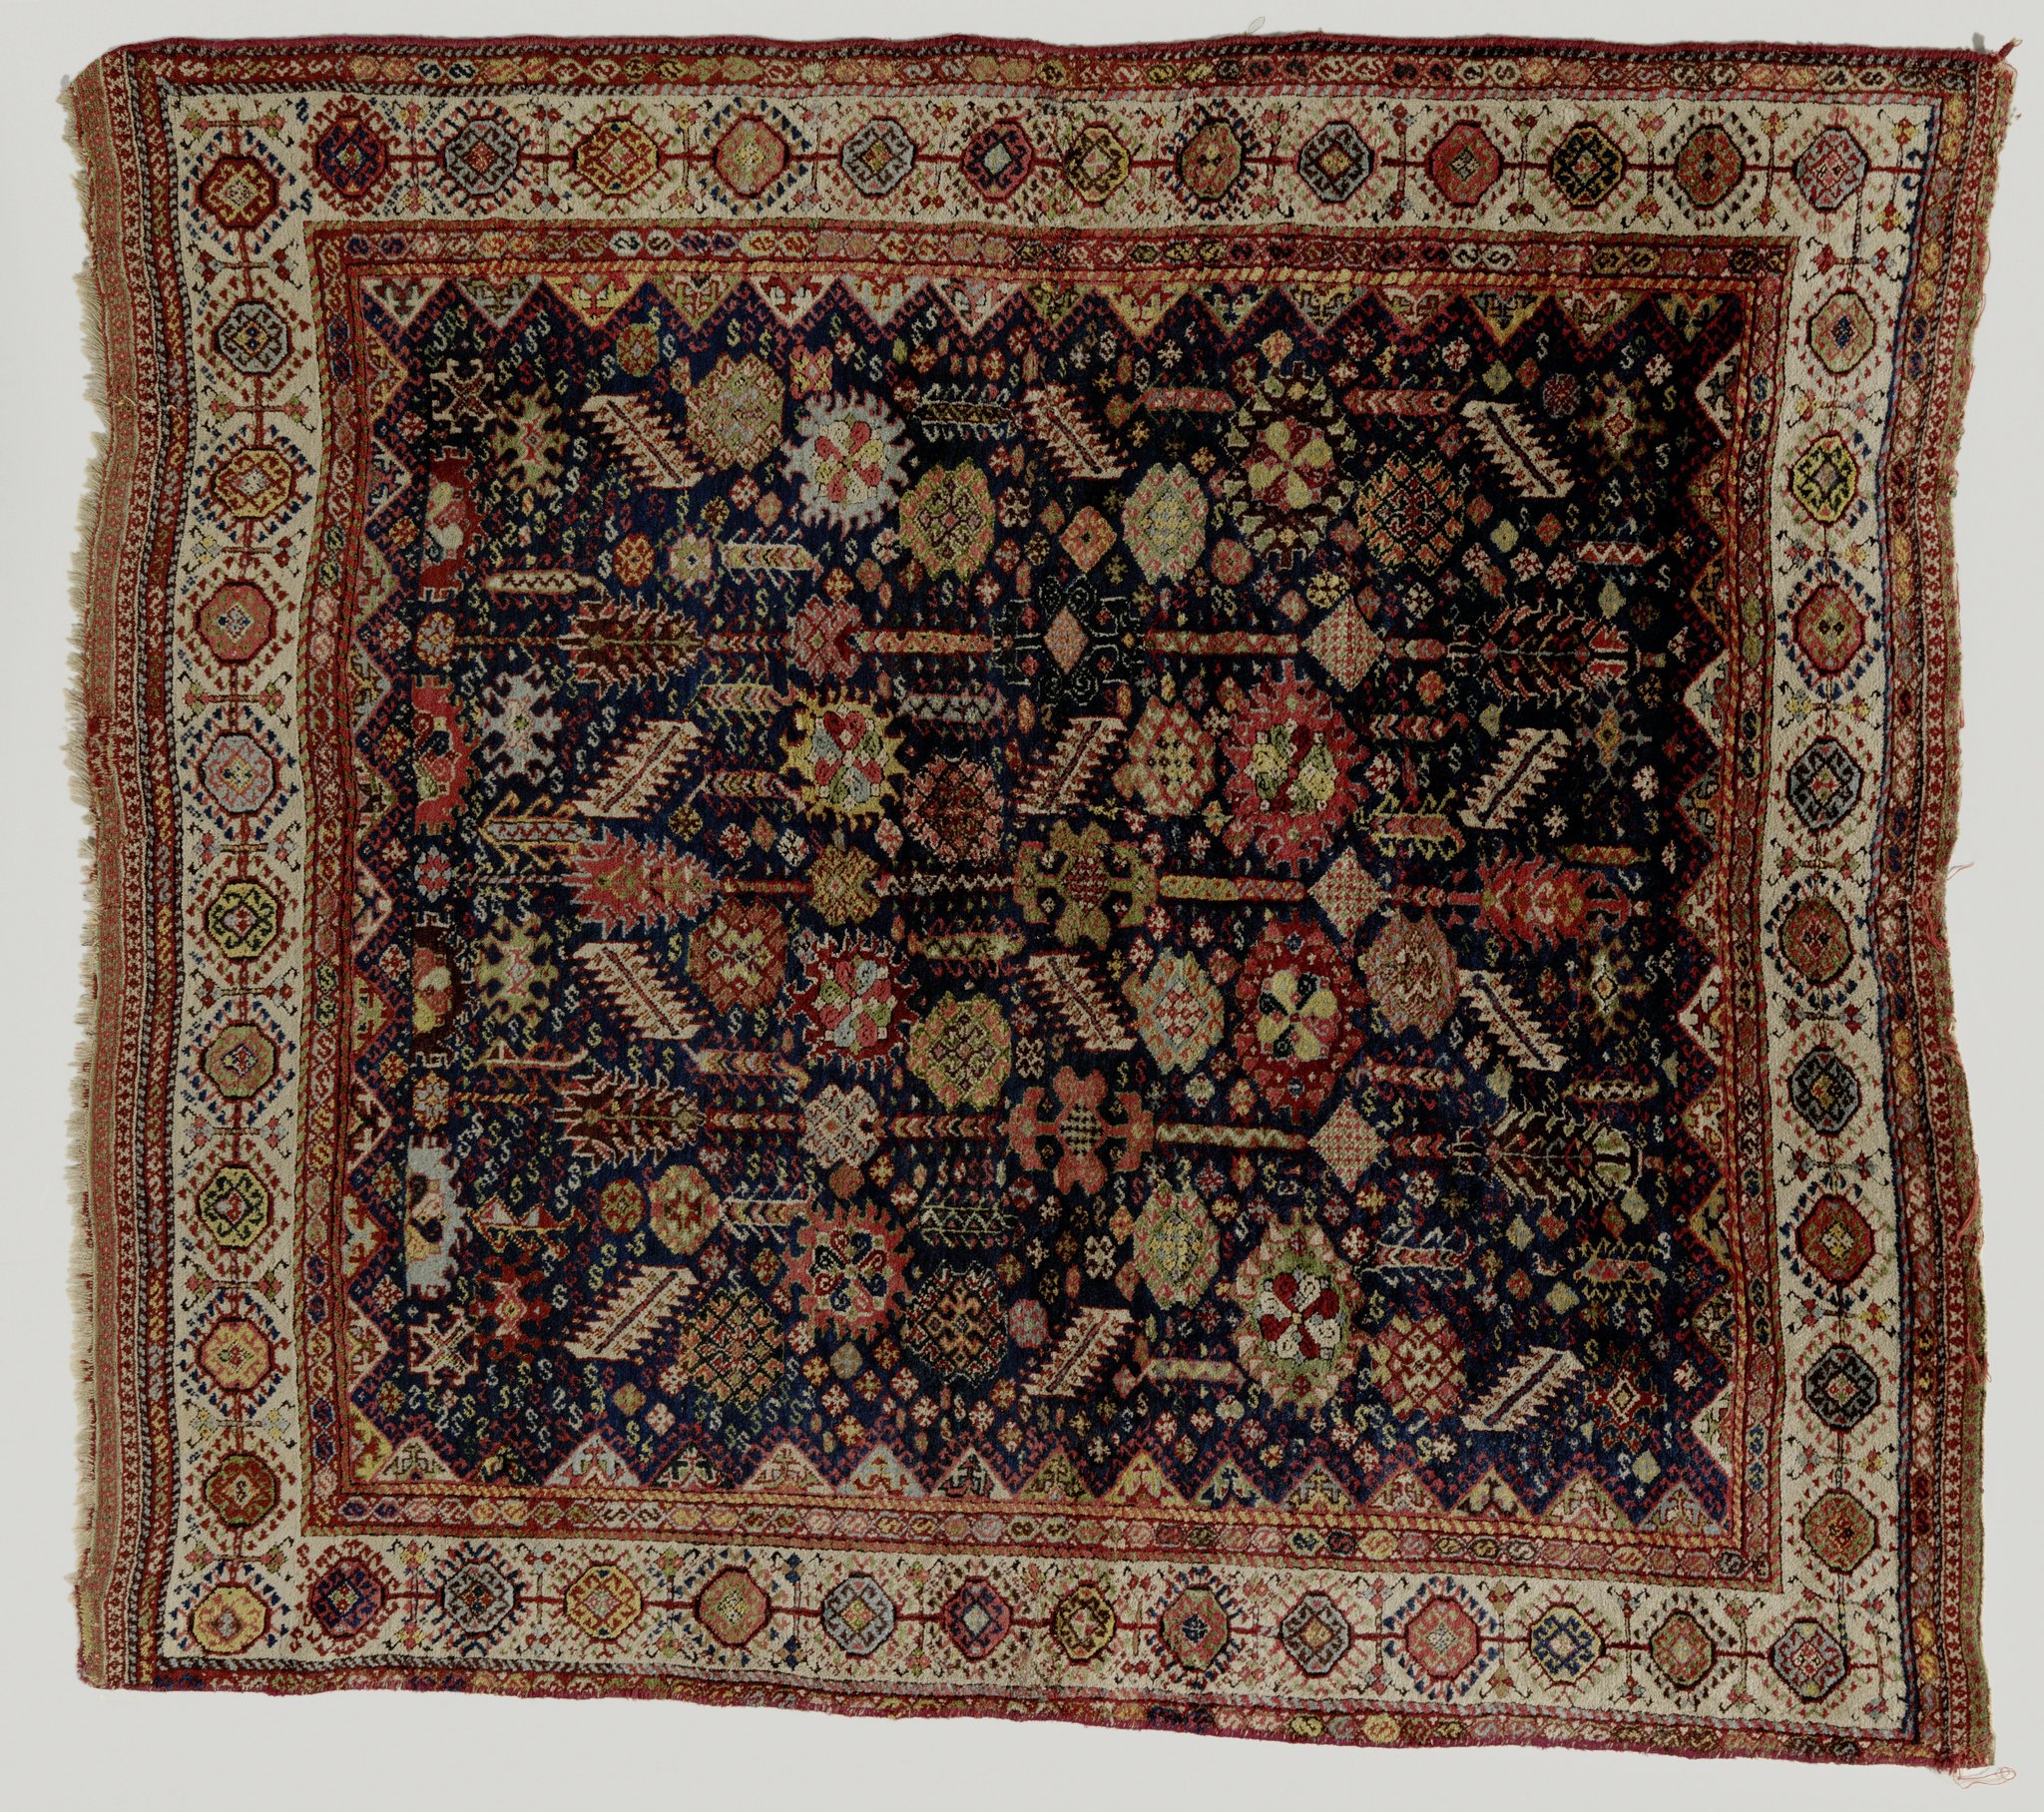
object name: oriental rug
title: Oosters tapijt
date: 1800-1949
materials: wool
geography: shiraz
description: Oosters bloemenkleed van geknoopte wol met palmetten, rozetten, ruiten met haken op een donkerblauw fond. Rand versierd met achthoeken.